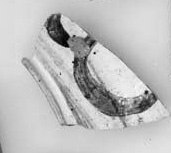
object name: shard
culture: korean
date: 1401-1500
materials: pottery